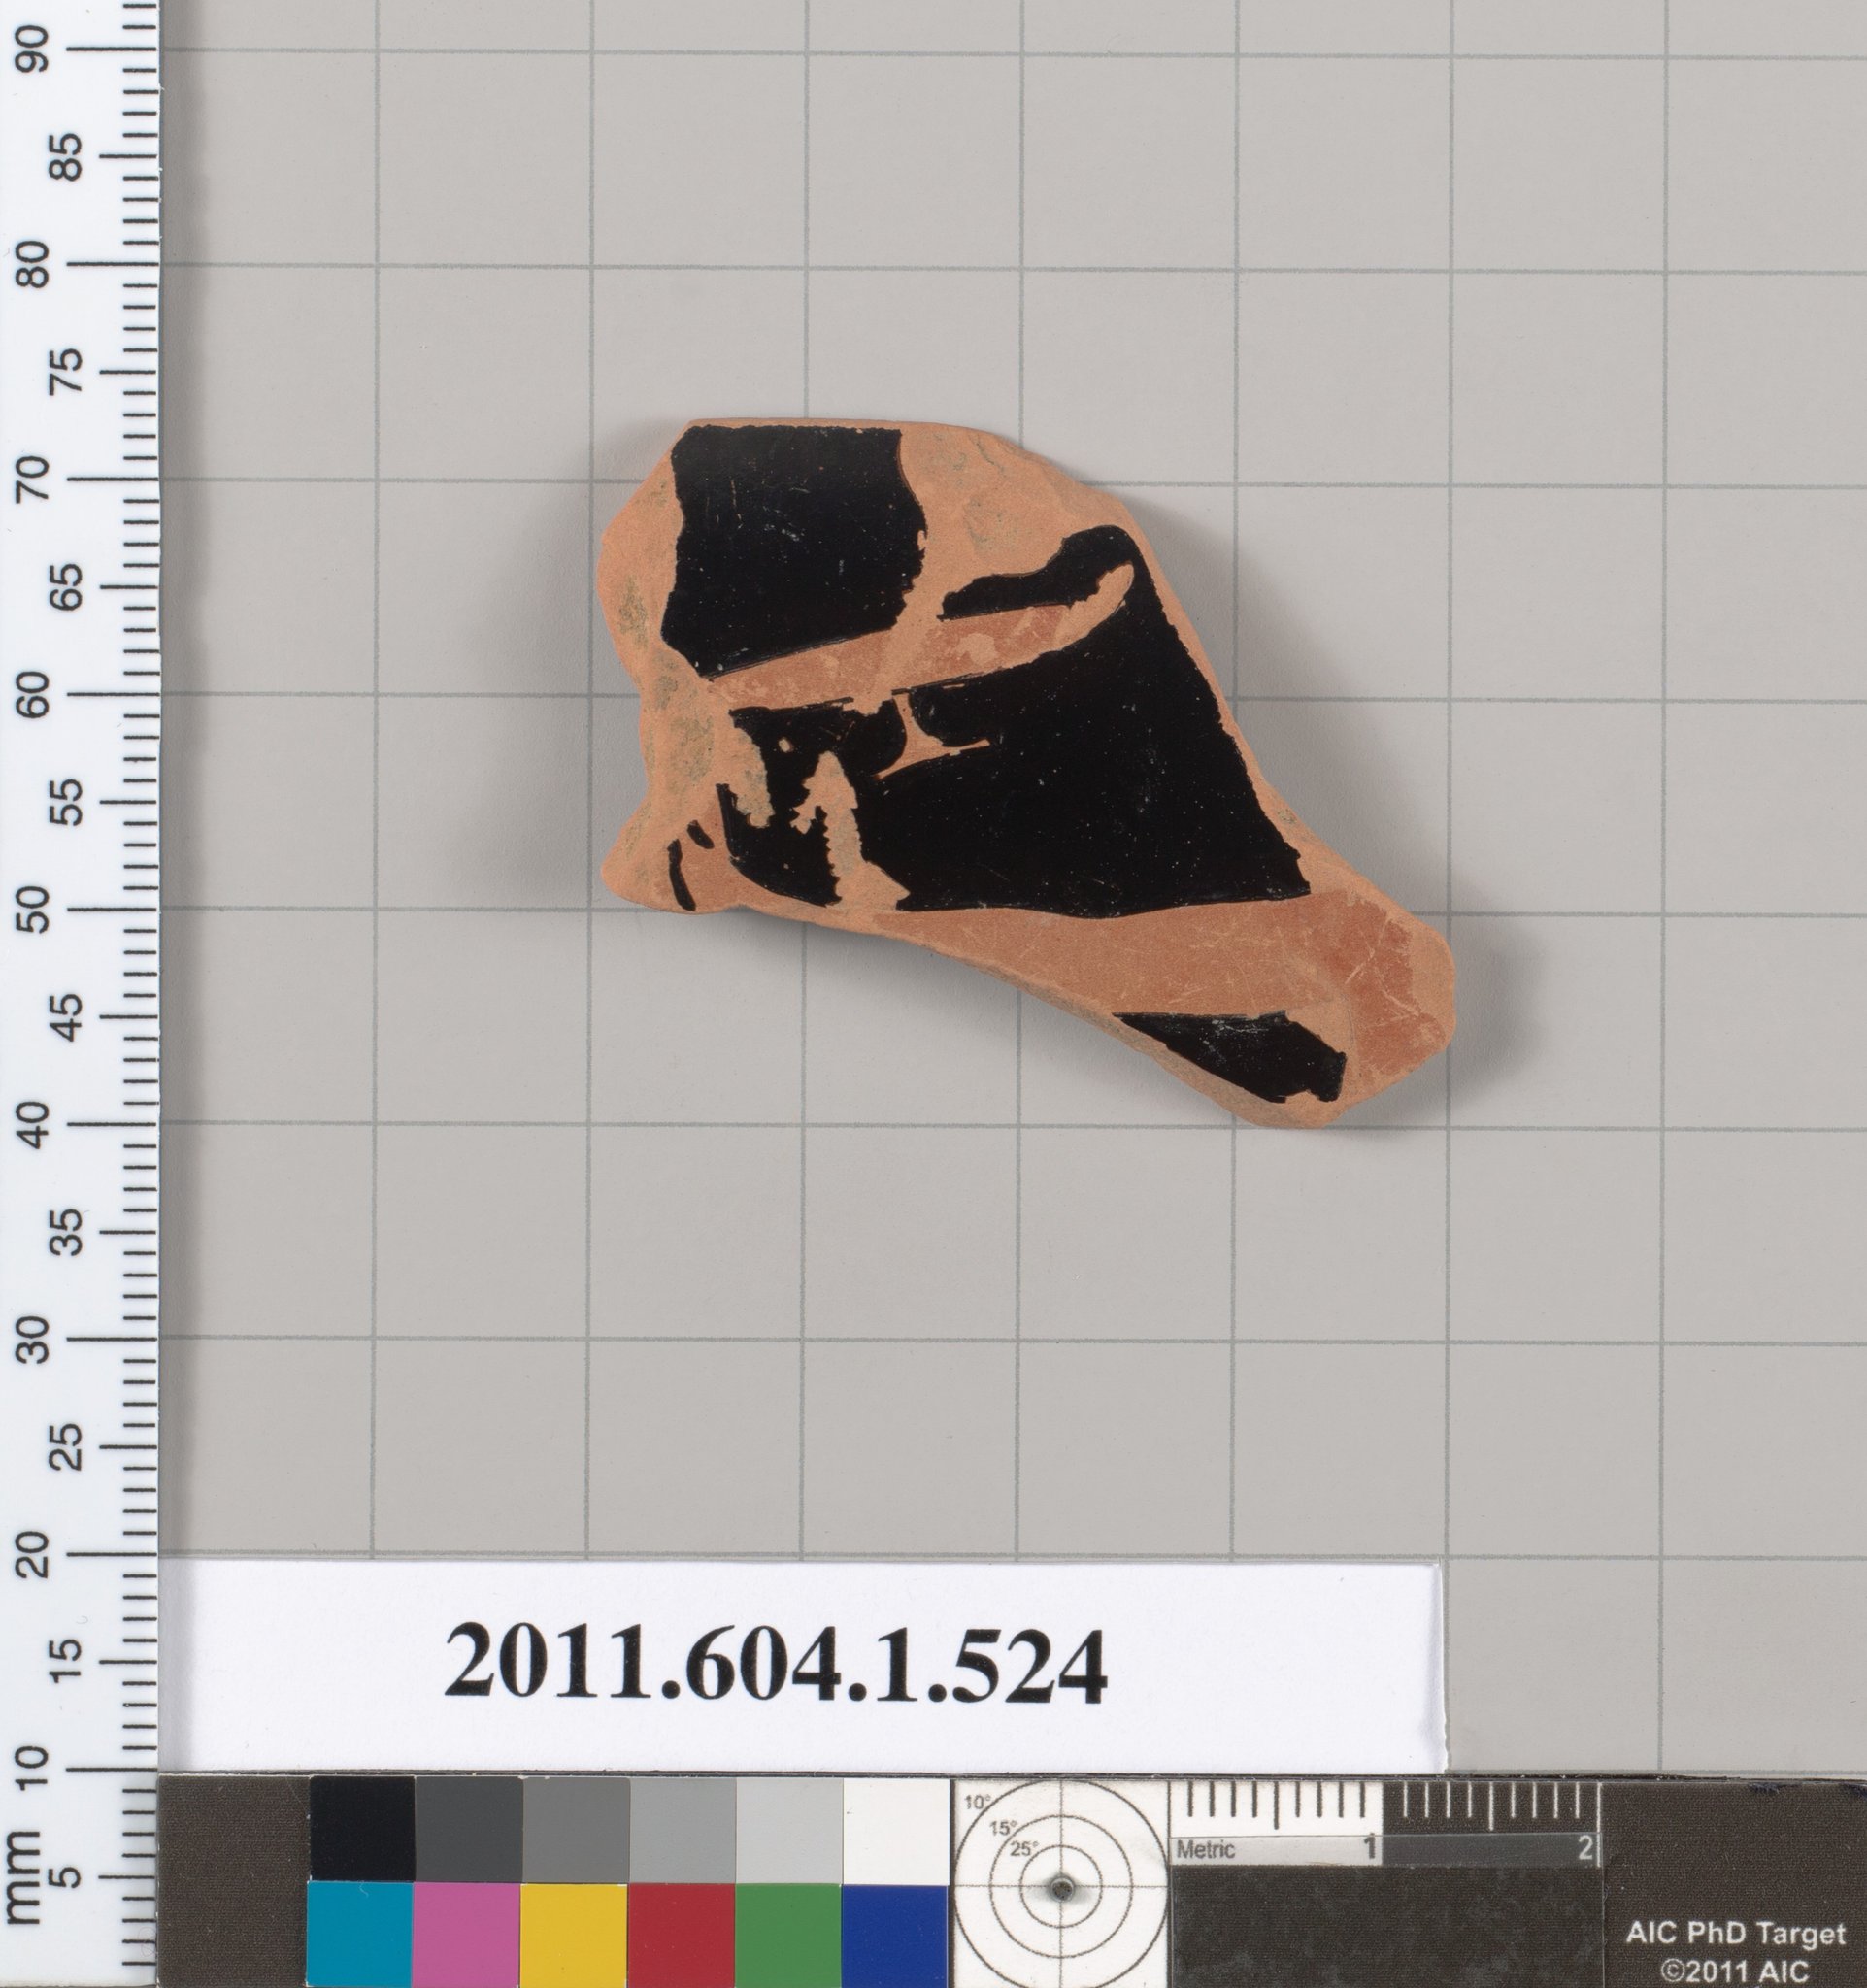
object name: kylix fragment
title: Terracotta rim fragment of a kylix (drinking cup)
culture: greek, attic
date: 490-480 BCE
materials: terracotta